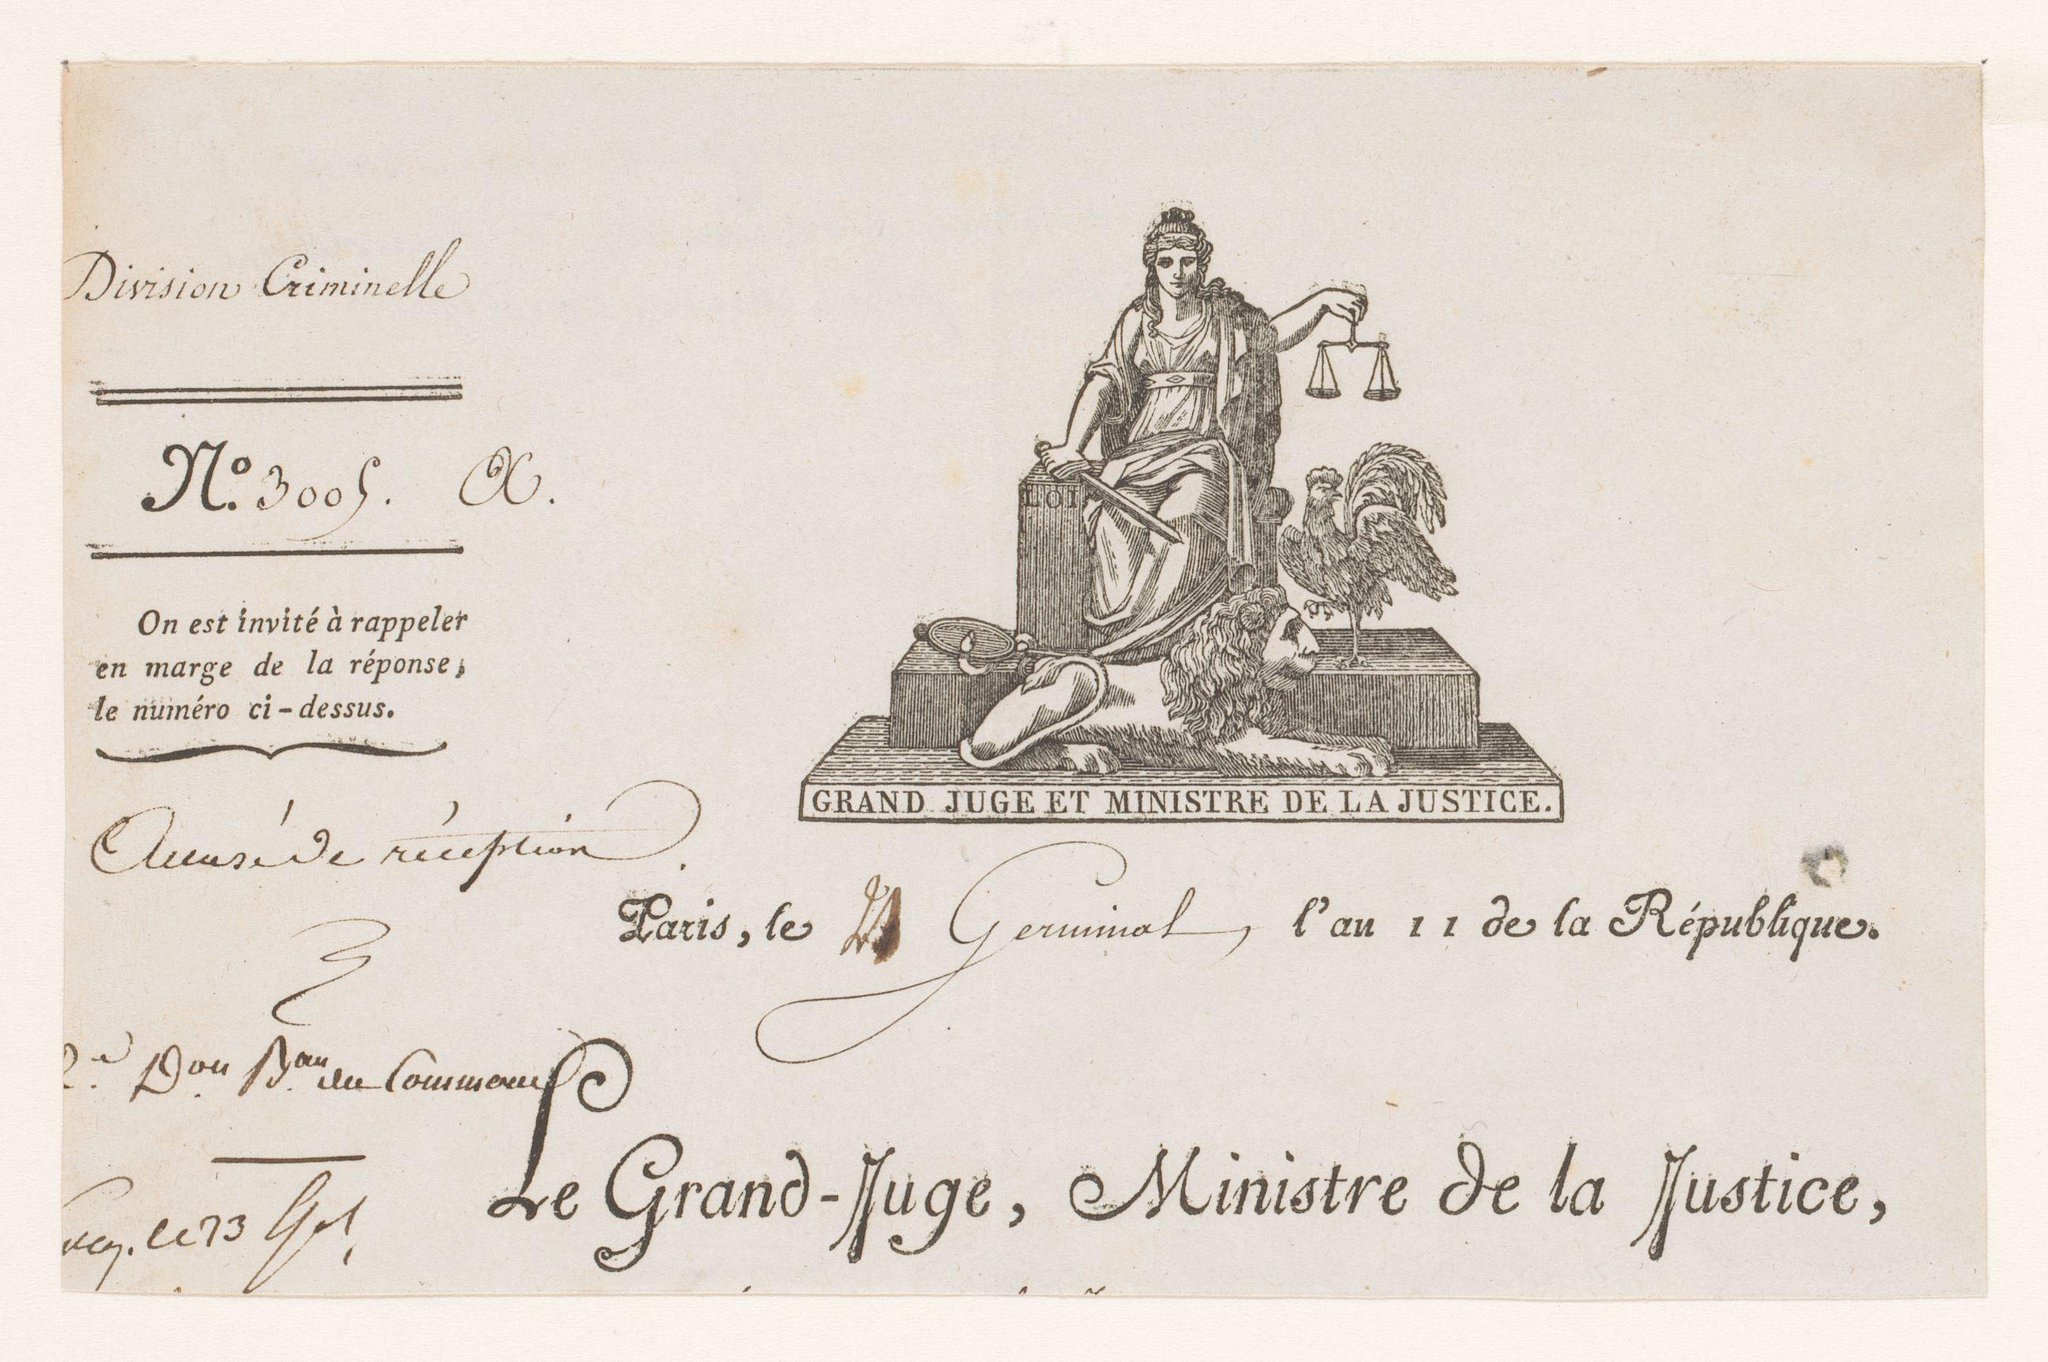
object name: print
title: Briefhoofd voor het Franse ministerie van Justitie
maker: gautherot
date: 1800-1803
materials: paper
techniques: engraving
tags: justitia (justice) as roman personification, law and jurisprudence, letter, envelope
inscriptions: collector's mark: Lugt 2228, : ‘Paris, le 21 Germinal, l'an 11 de la République. (...)’